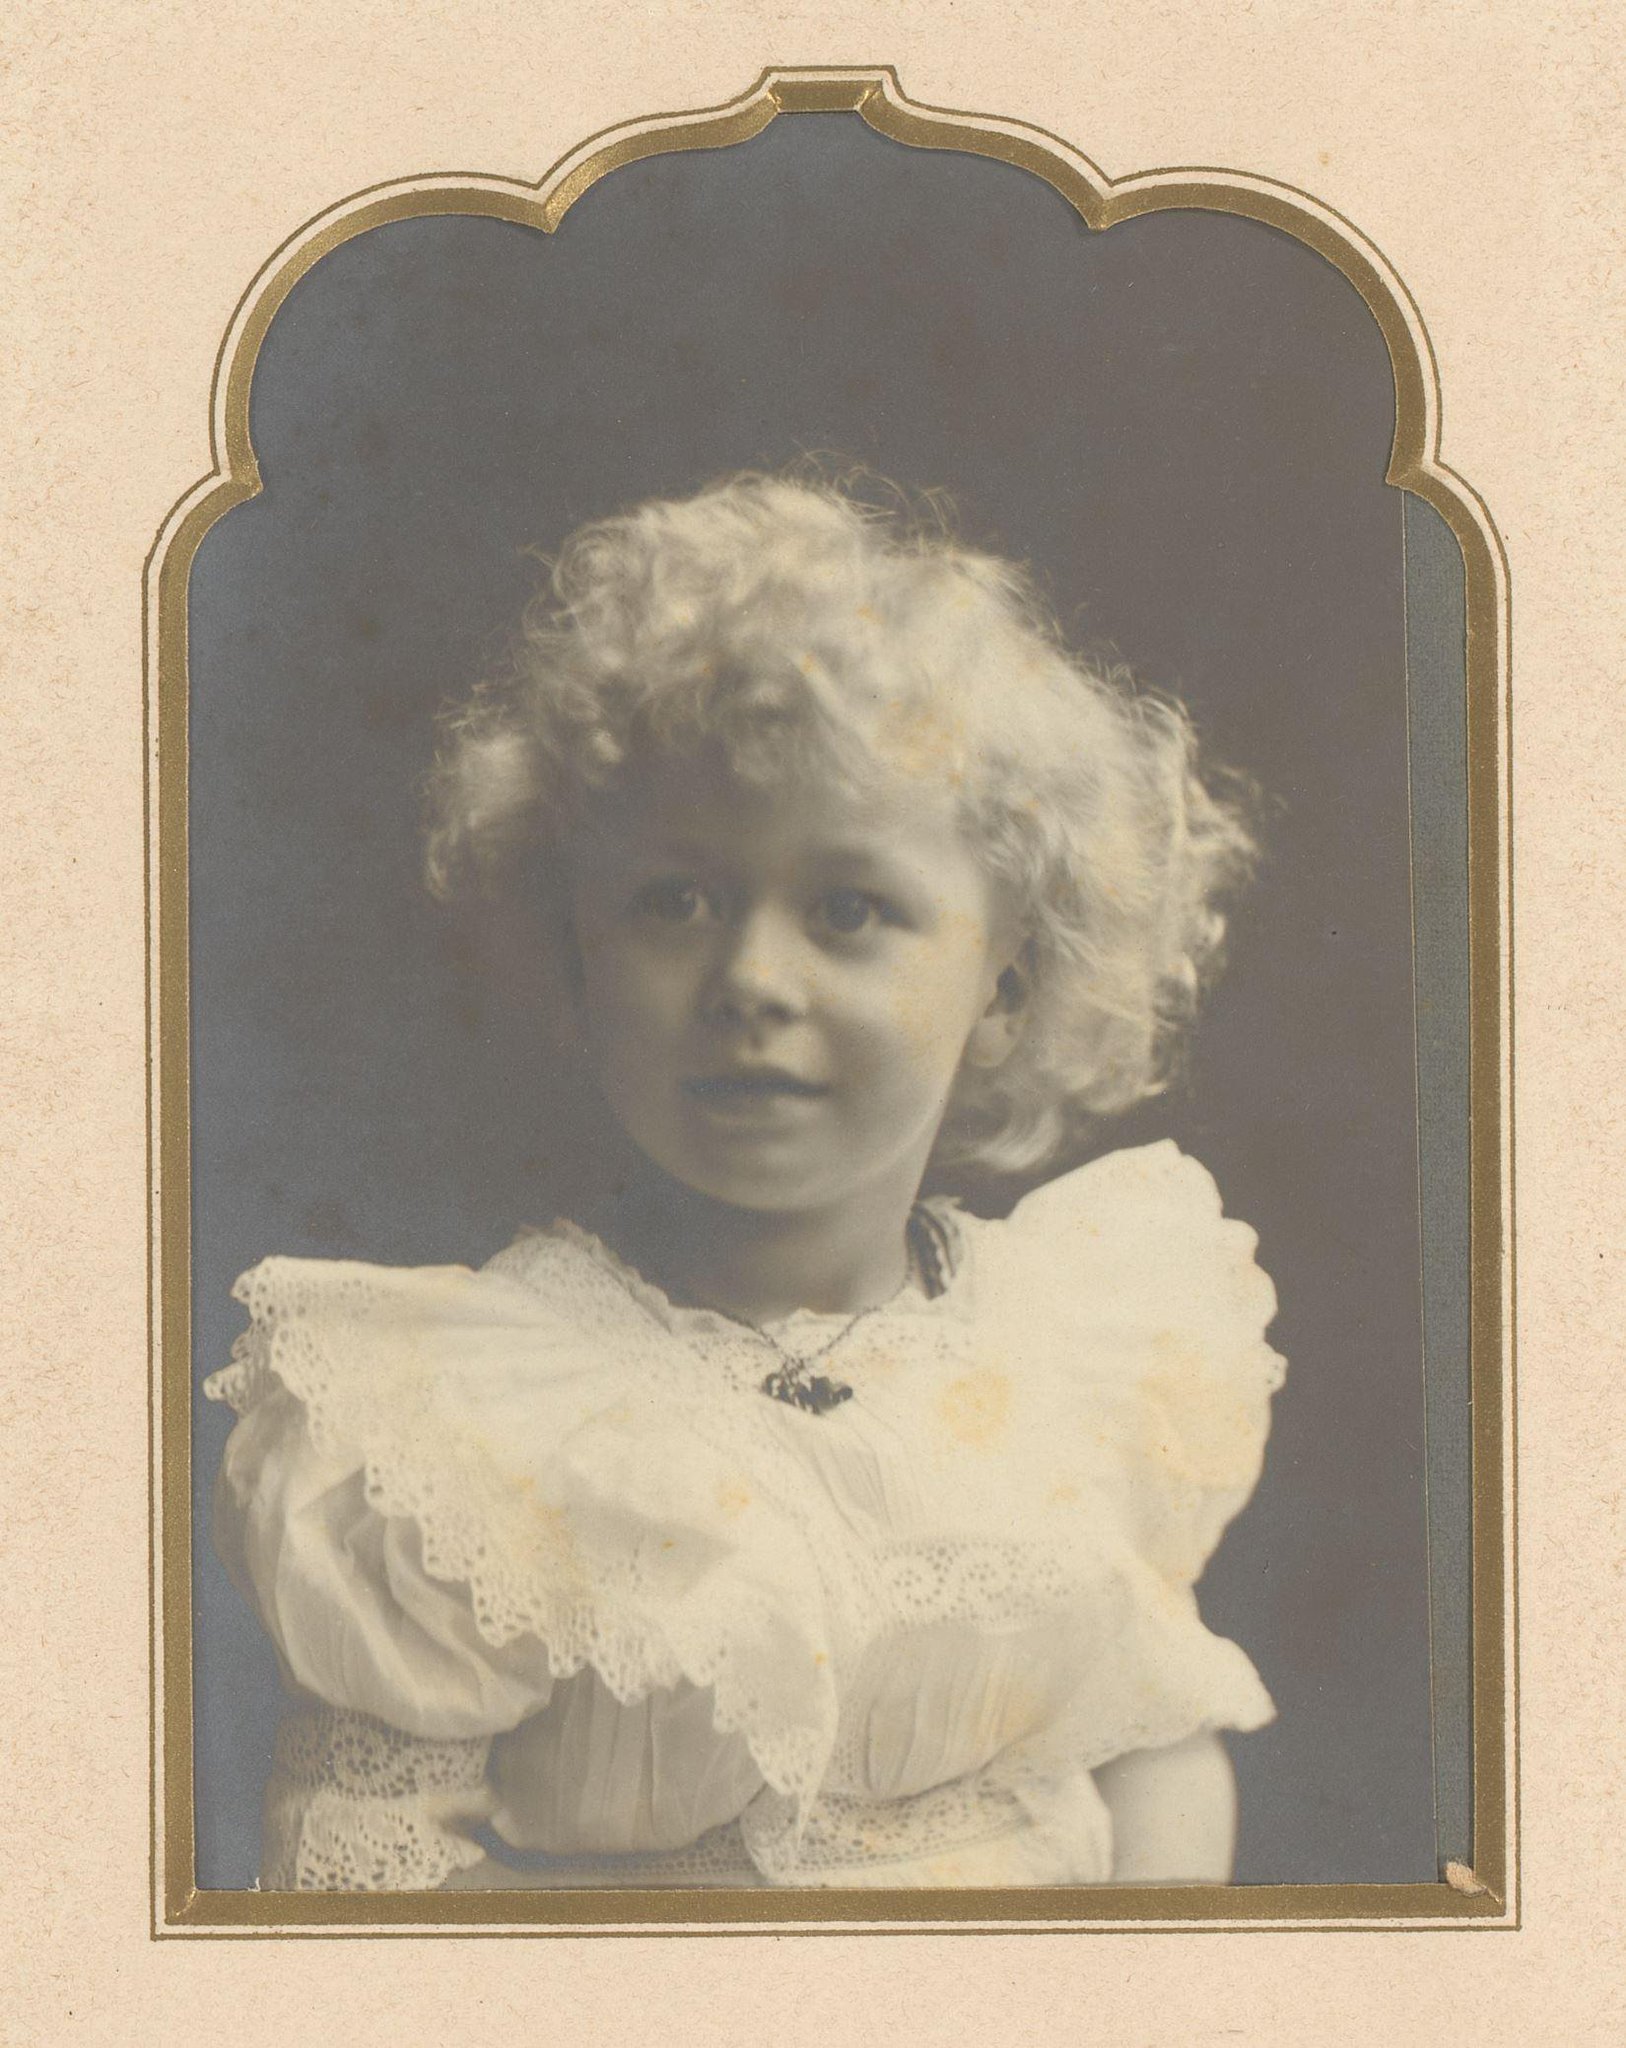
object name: cabinet photograph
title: Portret van een meisje met krullen in witte jurk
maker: adriaan boer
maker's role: fotograaf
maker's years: 1875-1940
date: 1897-1912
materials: cardboard, photographic support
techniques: gelatin silver print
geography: baarn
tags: girl (child between toddler and youth)